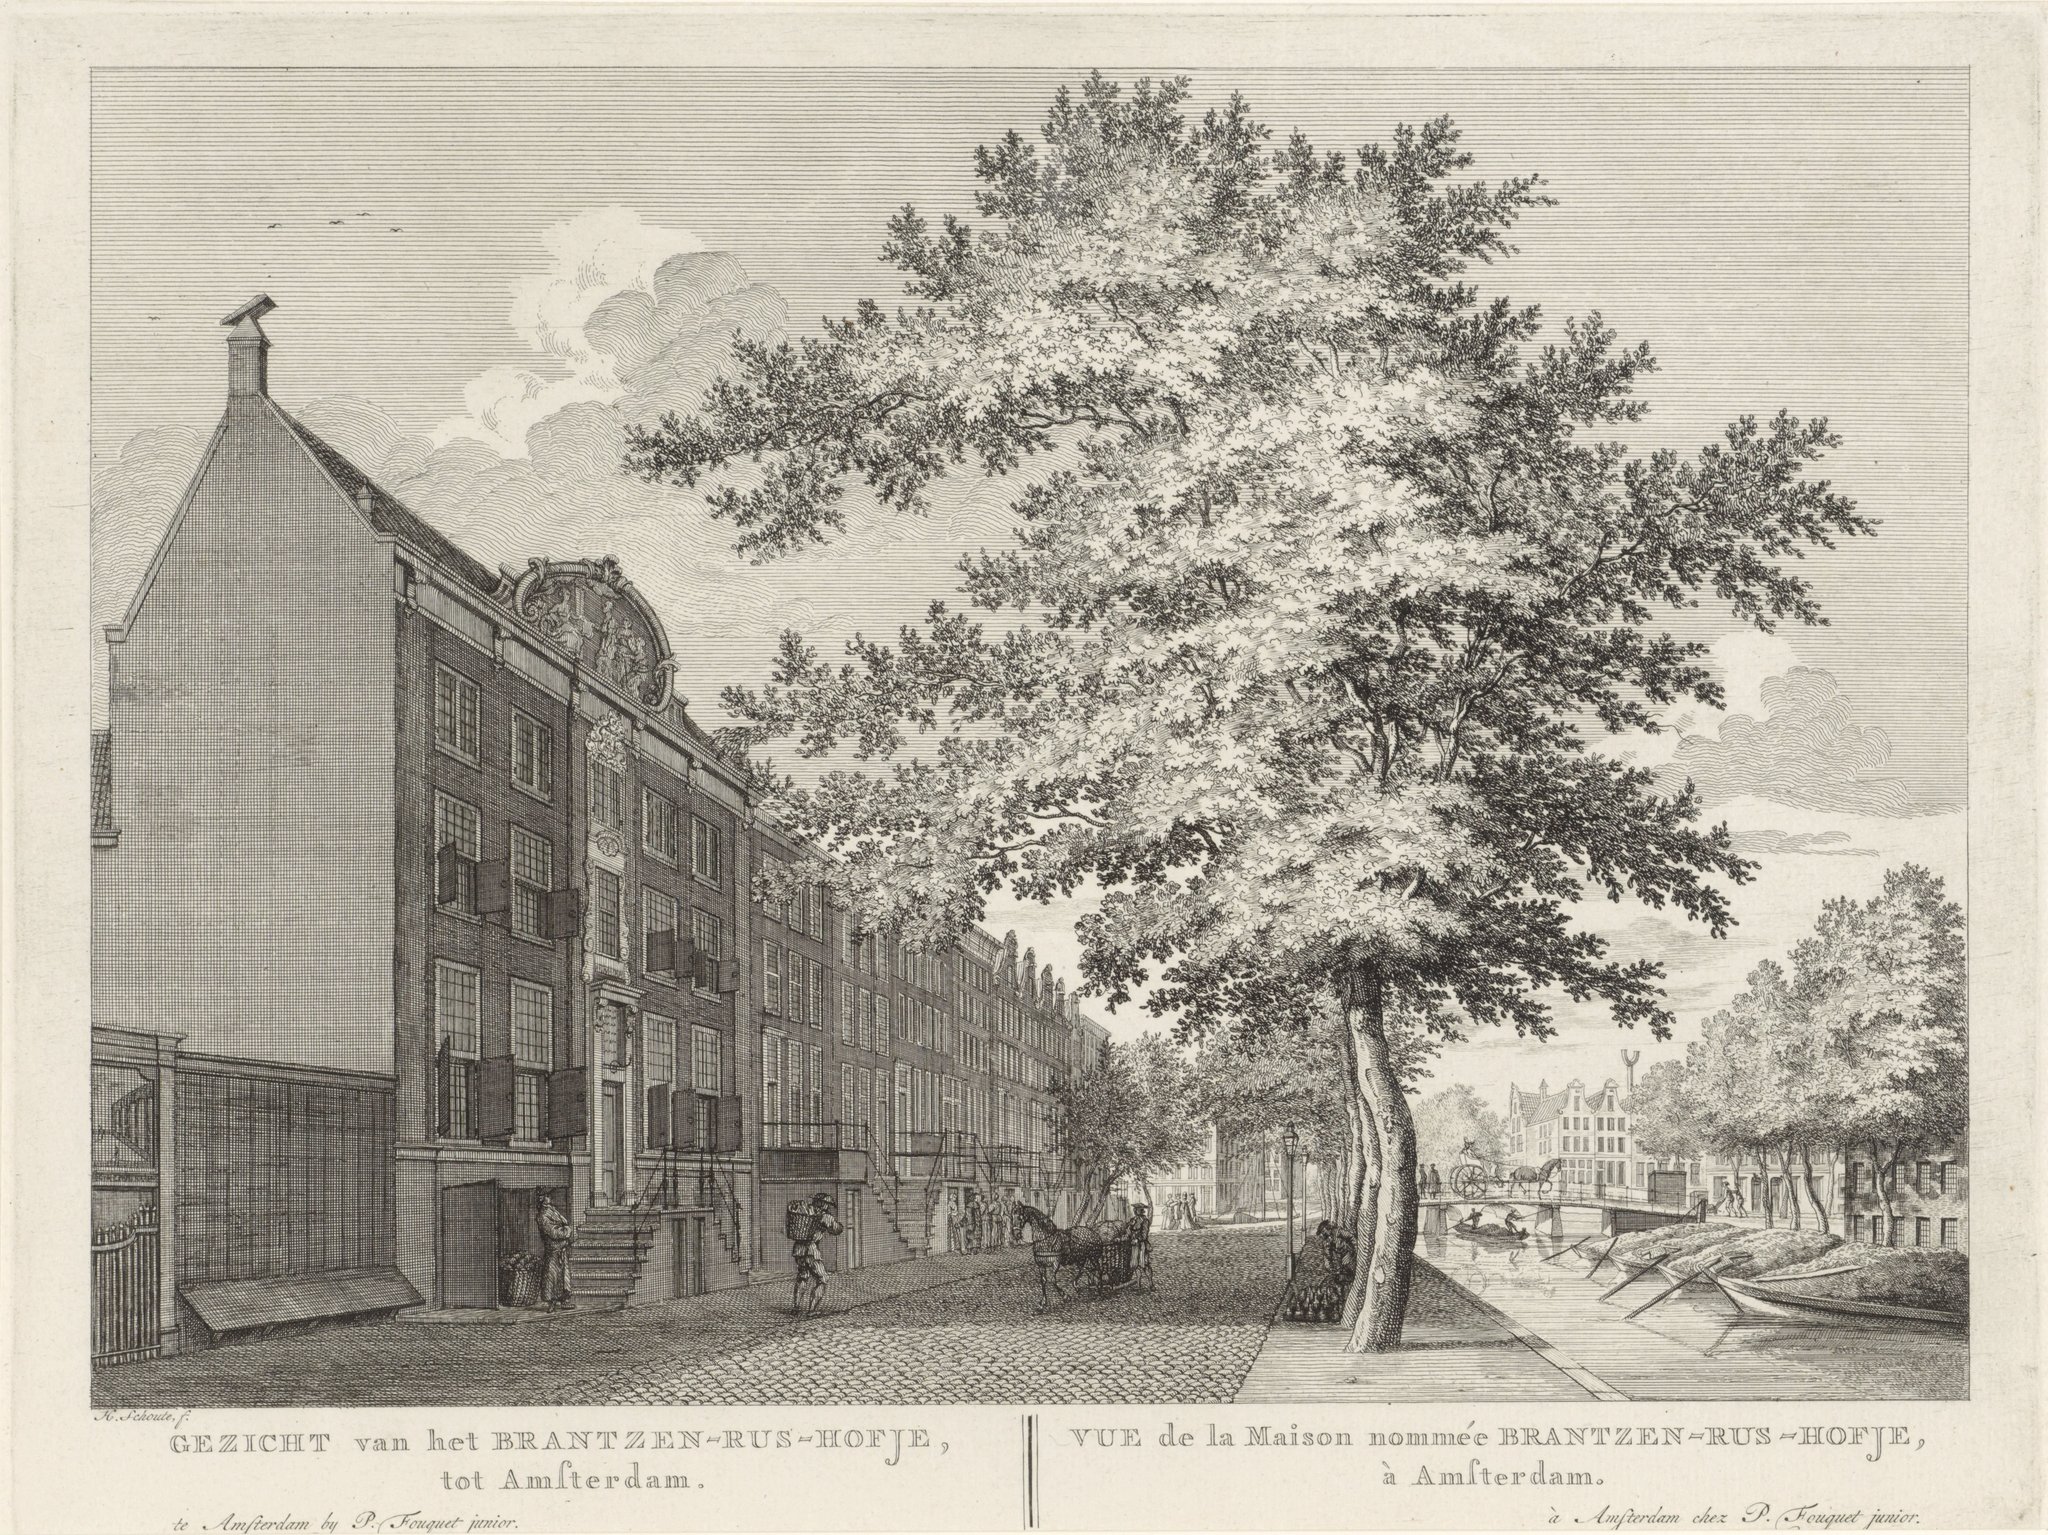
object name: print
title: Gezicht van het Brantzen-Rus-Hofje, tot Amsterdam / Vue de la Maison nommée Brantzen-Rus-Hofje, à Amsterdam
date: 1770-1783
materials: paper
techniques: engraving, etching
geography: amsterdam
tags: alms-house (dutch: 'hofje'), bridge in city across river, canal, etc. (+ city(-scape) with figures, staffage), canals, waters (in city) (+ city(-scape) with figures, staffage), street (+ city(-scape) with figures, staffage)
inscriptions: collector's mark: Lugt 2233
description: Deze prent is ook gebruikt in de zogenaamde Atlas van Fouquet.* Pierre Fouquet gaf vanaf 1760 stadsgezichten van Amsterdam - naar tekeningen van verschillende kunstenaars, gemaakt door verschillende prentmakers - uit. Deze prenten werden aanvankelijk los of in series verkocht. Zoals toen gebruikelijk kon de koper de prenten zelf laten inbinden. Hiertoe gaf Fouquet tussen 1778 en 1783 een titelblad, plattegrond en inhoudsopgave van de tot dusver 100 uitgegeven prenten uit (1). Gezien de inhoud afhankelijk was van wat de koper had verzameld verschilt de inhoud van de verschillende bewaarde Fouquetatlassen onder deze titel sterk. Ook zijn er exemplaren bekend waar tevens andere prenten aan zijn toegevoegd. Omdat er behoefte bleek aan uitleg bij de platen werd in 1783 een nieuwe versie van de atlas uitgegeven, aangevuld met tekst en twee prenten. De aangegeven volgorde veranderde maar de platen van de al eerder uitgegeven prenten bleven ongewijzigd. Deze uitgave werd in opdracht van Fouquet gedrukt bij Daniël Jean Changuion en Petrus den Hengst (2). Een tiental platen werd bijgewerkt en verscheen, met nieuw impressum, in het vervolg van Wagenaars geschiedenis van Amsterdam, uitgeven door Petrus Conradi en Folkert van der Plaats (3). Een aantal jaar na het overlijden van Fouquet kwam Evert Maaskamp met een nieuwe uitgave van de atlas, met verbeterde tekst en toevoeging van twee prenten. Op alle platen verwijderde hij het oude en liet hij zijn eigen impressum zetten (4). De huidige staat van de prent komt voor in exemplaren van de onder (1) en (2) genoemde werken. * Onder de Atlas van Fouquet of Fouquetatlas verstaan we de hieronder vermelde publicaties (1), (2) en (4). (1). Afbeeldingen van de wyd-vermaarde koopstad Amsterdam benevens des zelvs voornaamste gebouwen en gezigten alle naar het leeven getekend / Receuil des edifices les plus considerables et des plus belles vues, de la fameuse ville d'Amsterdam, dessinées d'après nature. Amsterdam: Pierre Fouquet, 1778-1783. (2). Nieuwe atlas, van de voornaamste gebouwen en gezigten der stad Amsterdam, met derzelver beknopte beschryvingen. 2 delen. Amsterdam: Daniël Jean Changuion en Petrus den Hengst [in opdracht van Pierre Fouquet], 1783. (3). Stijl, Simon. Amsterdam, in zyne geschiedenissen, voorregten, koophandel, gebouwen, kerkenstaat, schoolen, schutterye, gilden en regeeringe, beschreeven. Om te dienen ten vervolge op het werk van Jan Wagenaar (…). 10 delen. Amsterdam en Harlingen: Petrus Conradi en Folkert van der Plaats, 1788-1801. (4). Nieuwe atlas, van de voornaamste gebouwen en gezigten der stad Amsterdam. Met derzelver beknopte beschryvingen. Amsterdam: Evert Maaskamp, 1805. * Het aantal vermelde staten is gebaseerd op het aantal gevonden staten. Mogelijk zijn er meer staten van deze prent. Voor eerste bekende staat zie RP-P-1921-563. Voor derde bekende staat zie RP-P-1905-797. Voor vierde bekende staat zie RP-P-1998-763.